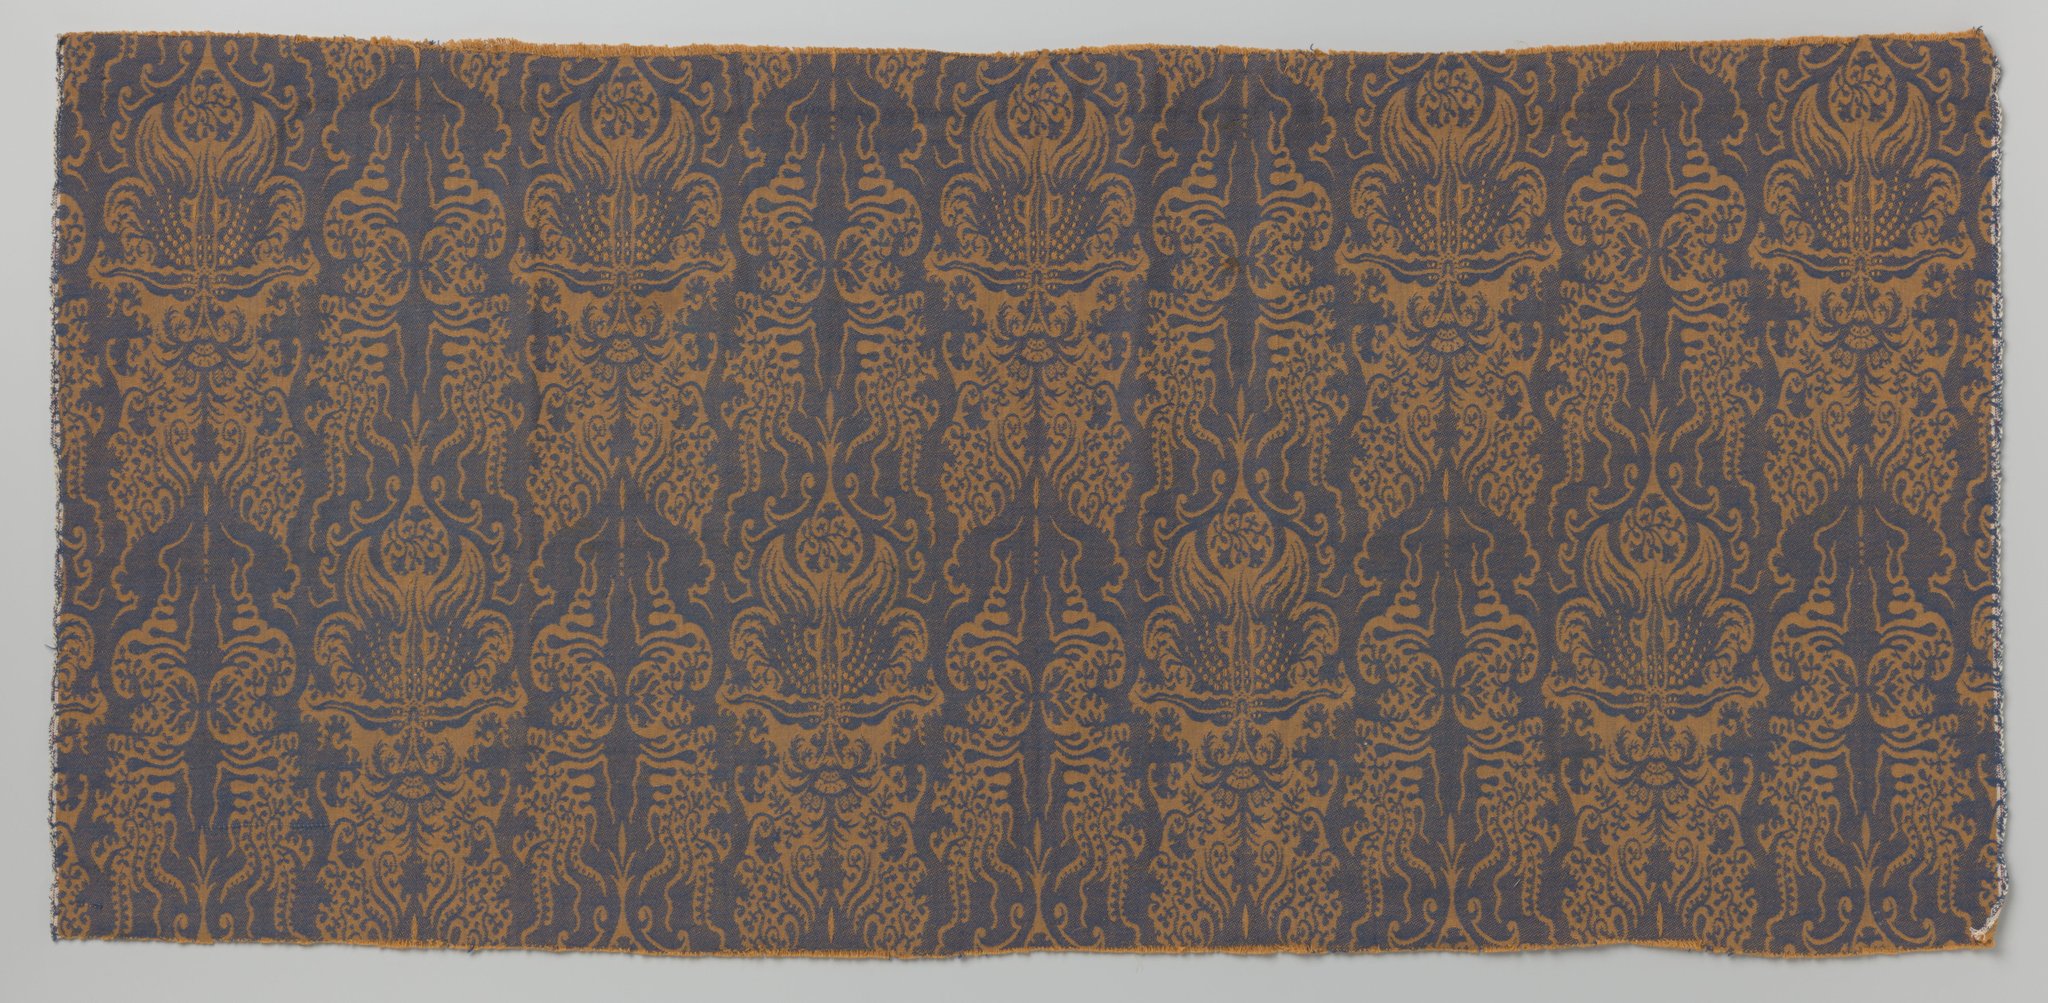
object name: woven material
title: Fragment jacquardweefsel met patroon "Orchidee"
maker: roelf gerbrands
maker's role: designer, draughtsman, print maker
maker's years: 1891-1954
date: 1920-1924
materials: cotton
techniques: jacquard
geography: oss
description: Fragment dubbelweefsel in jaquardtechniek, in lavendelblauw op okerkleurige grond met het patroon "orchidee", bestaande uit verspringende rijen bloemen in lavendelblauw op okerkleurige achtergrond. Aan de bovenkant van achterzijde is een klittenband bevestigd.